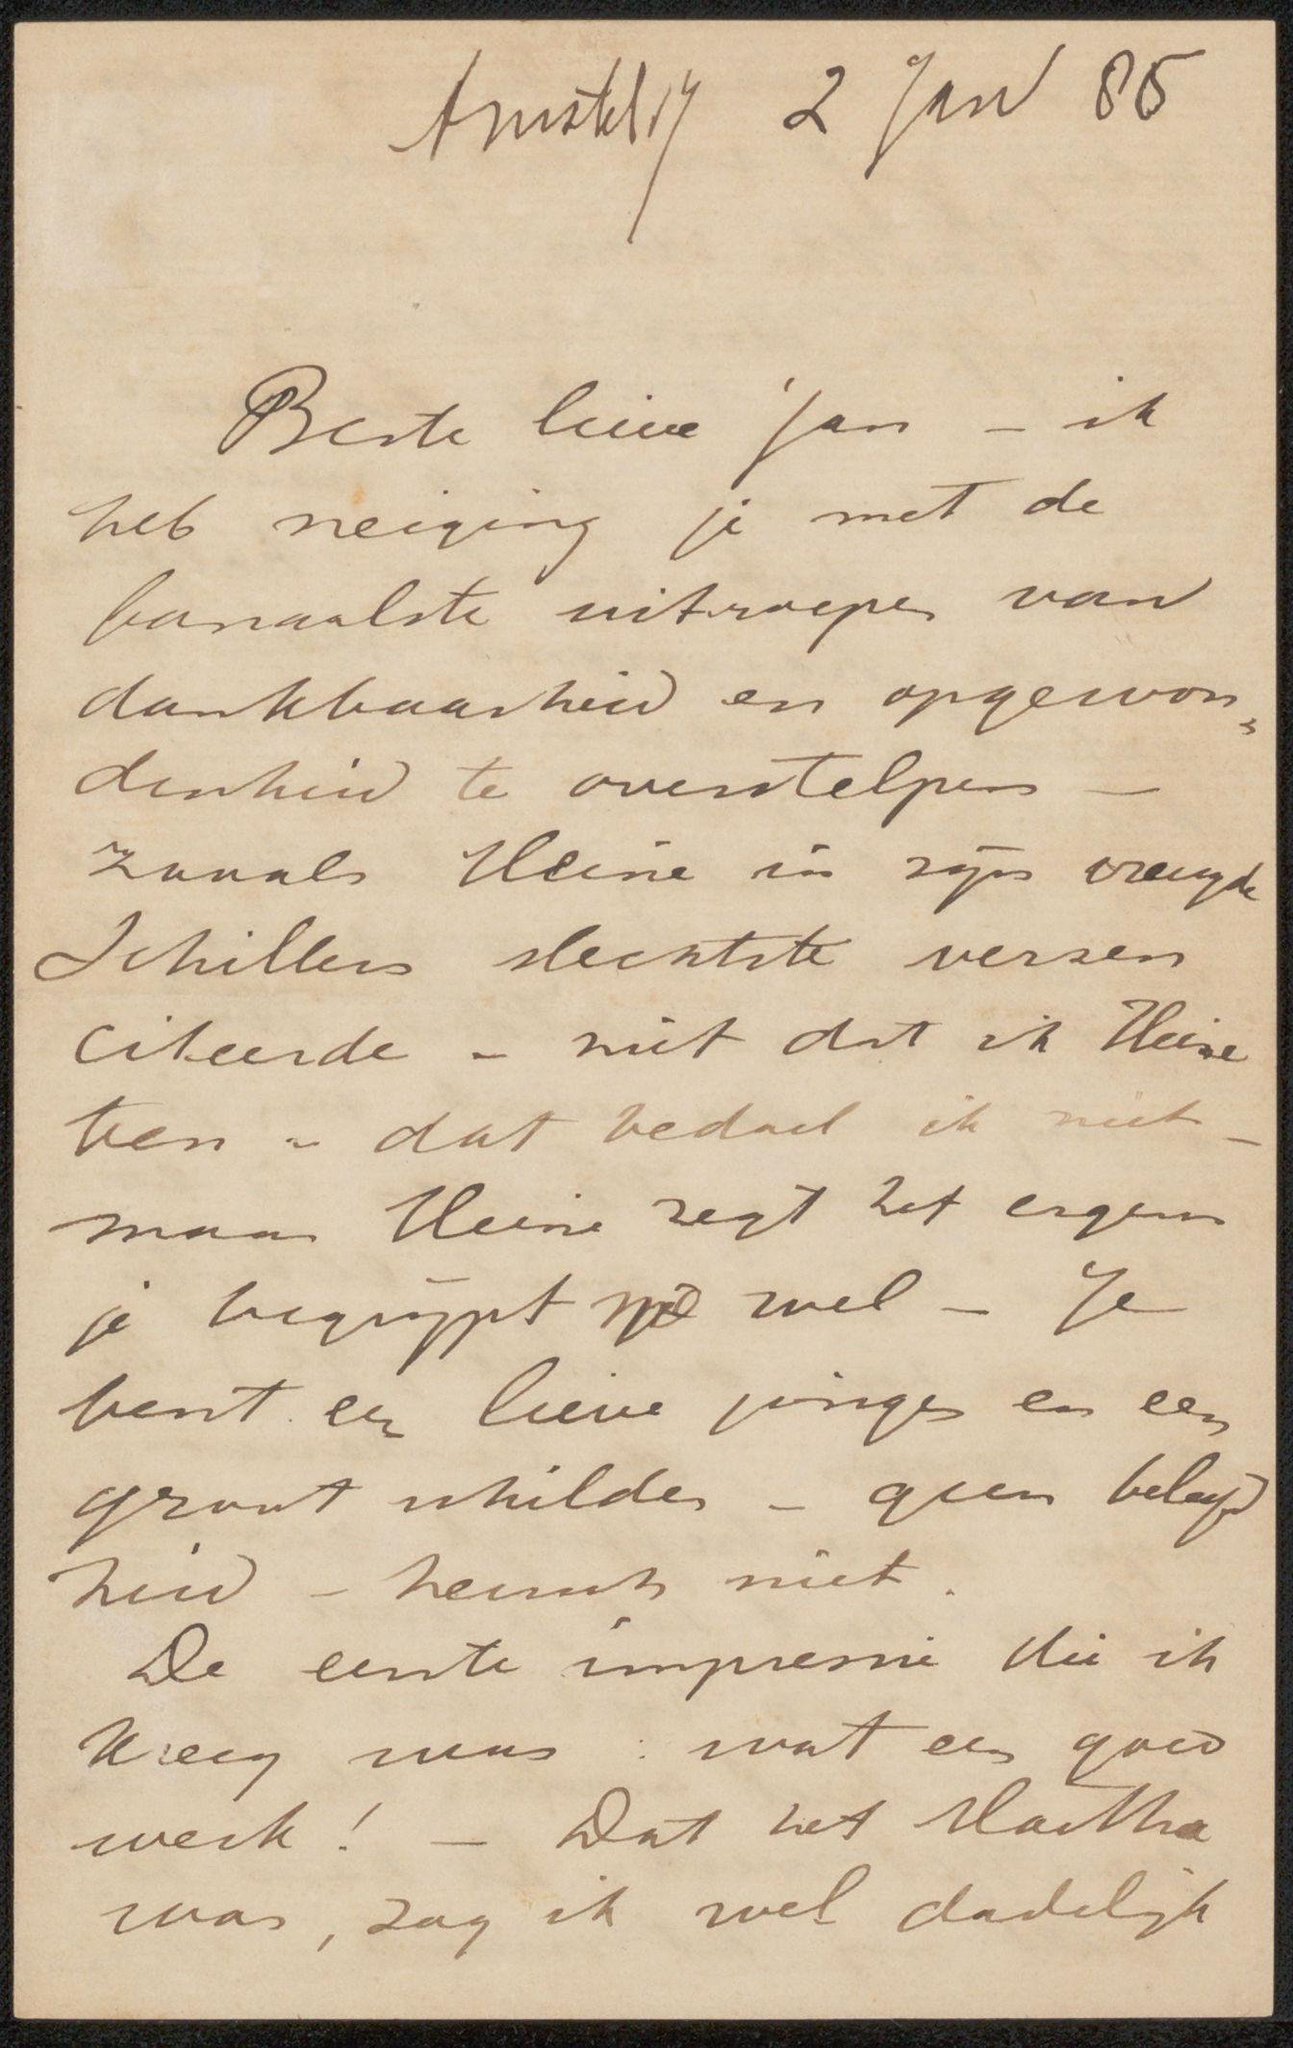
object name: letter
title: Brief aan Jan Veth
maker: frederik van eeden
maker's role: schrijver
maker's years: 1860-1932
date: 1885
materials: ink, paper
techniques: pen, writing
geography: amsterdam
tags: painter, draughtsman, designer, jan veth, amsterdam, albert verwey, deventer, martha van vloten, painting (including book-illumination, miniature-painting), historical persons (portraits and scenes from the life)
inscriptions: collector's mark: ‘RPK’